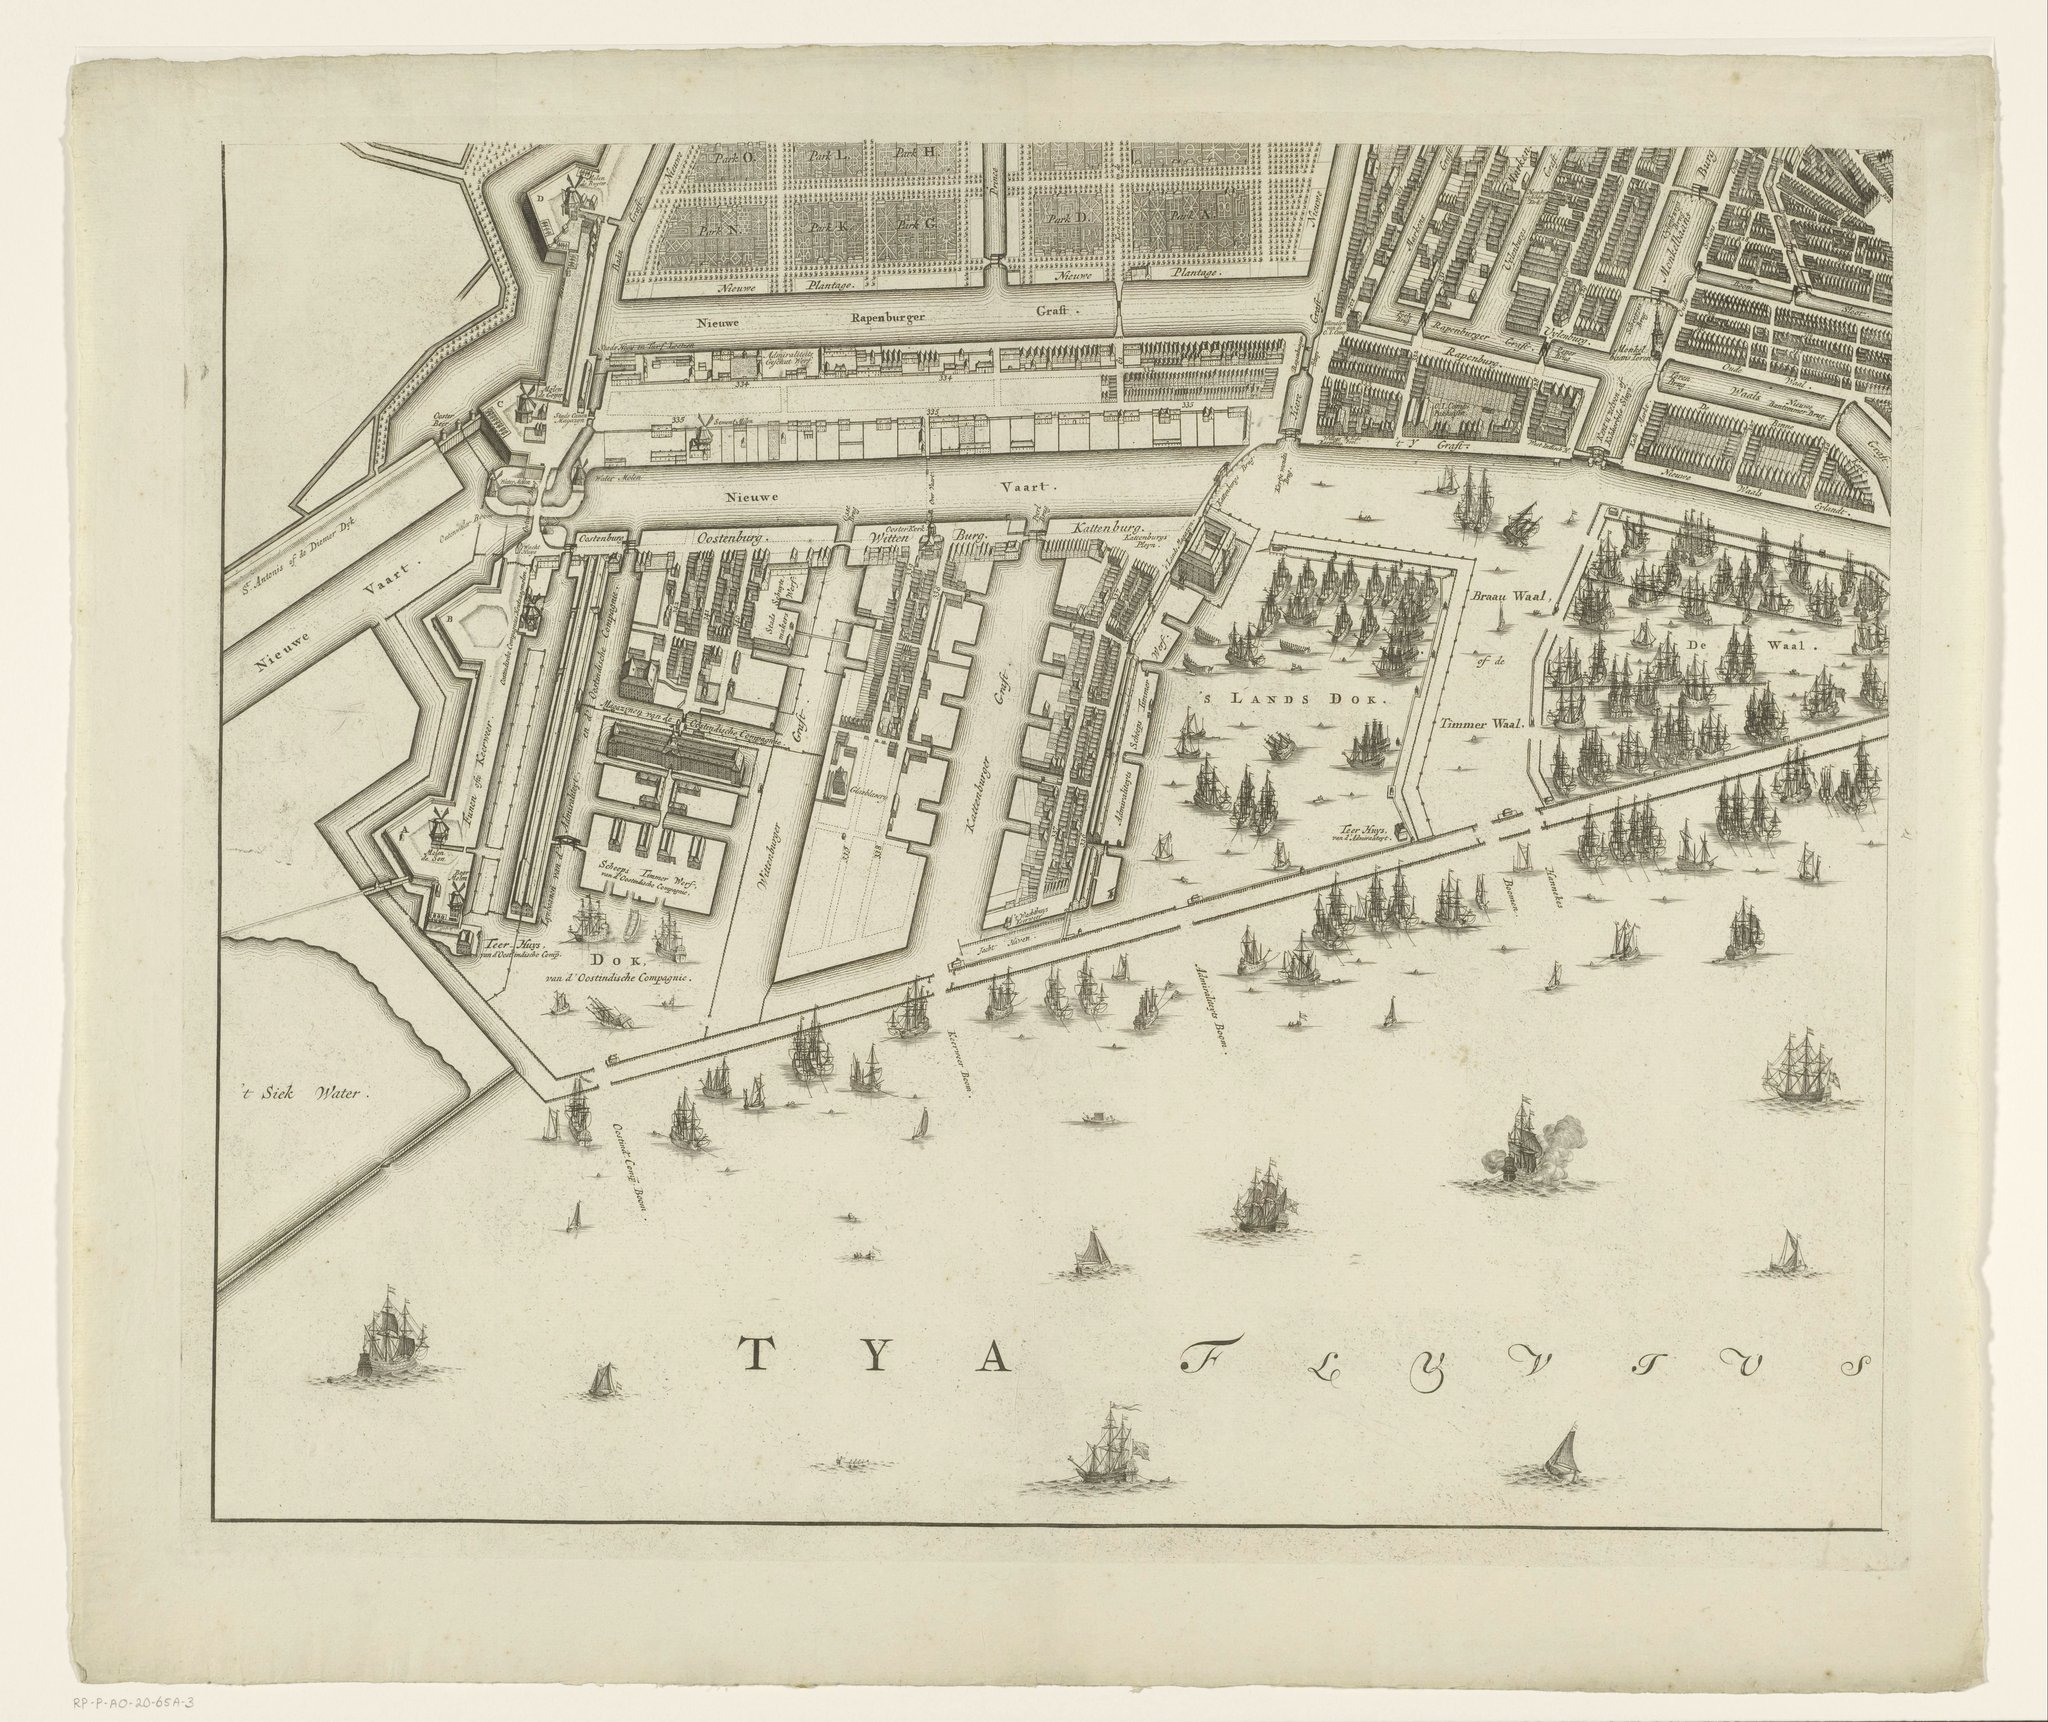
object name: area plan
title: Plattegrond van Amsterdam (deel linksonder)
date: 1724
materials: paper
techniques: engraving, etching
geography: amsterdam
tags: maps of cities, amsterdam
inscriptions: collector's mark: Lugt 2228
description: Deel (linksonder) van een plattegrond van Amsterdam, bestaande uit vier delen.